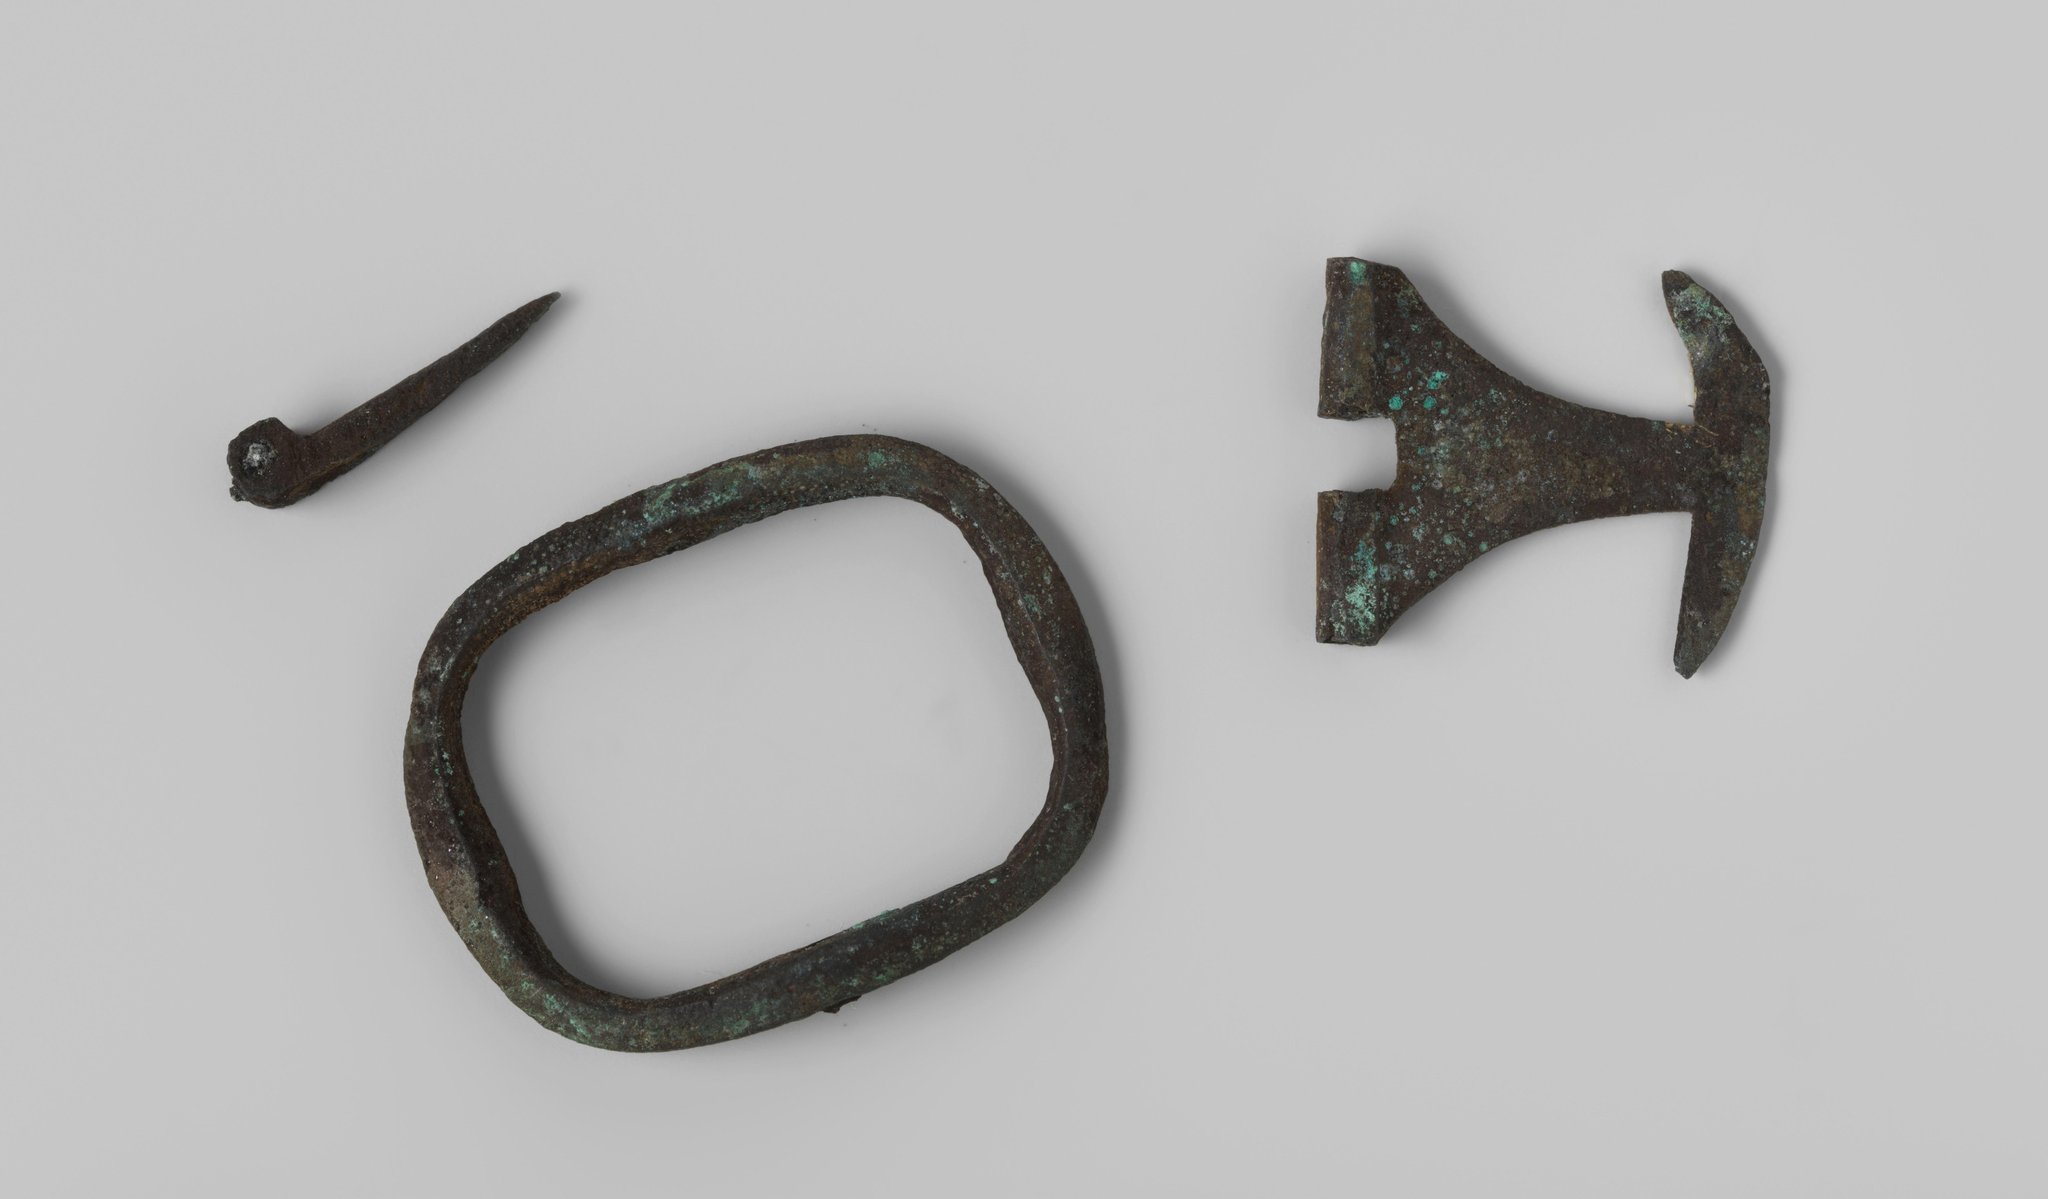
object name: knee buckle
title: Fragmenten kniegesp uit het wrak van de Oost-Indiëvaarder Hollandia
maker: Anonymous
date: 1700-1743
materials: copper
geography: netherlands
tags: verenigde oostindische compagnie, hollandia (schip), annet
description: Buckle, chape buckle, knee buckle; fragm: ring, plain, tongue, anchor.